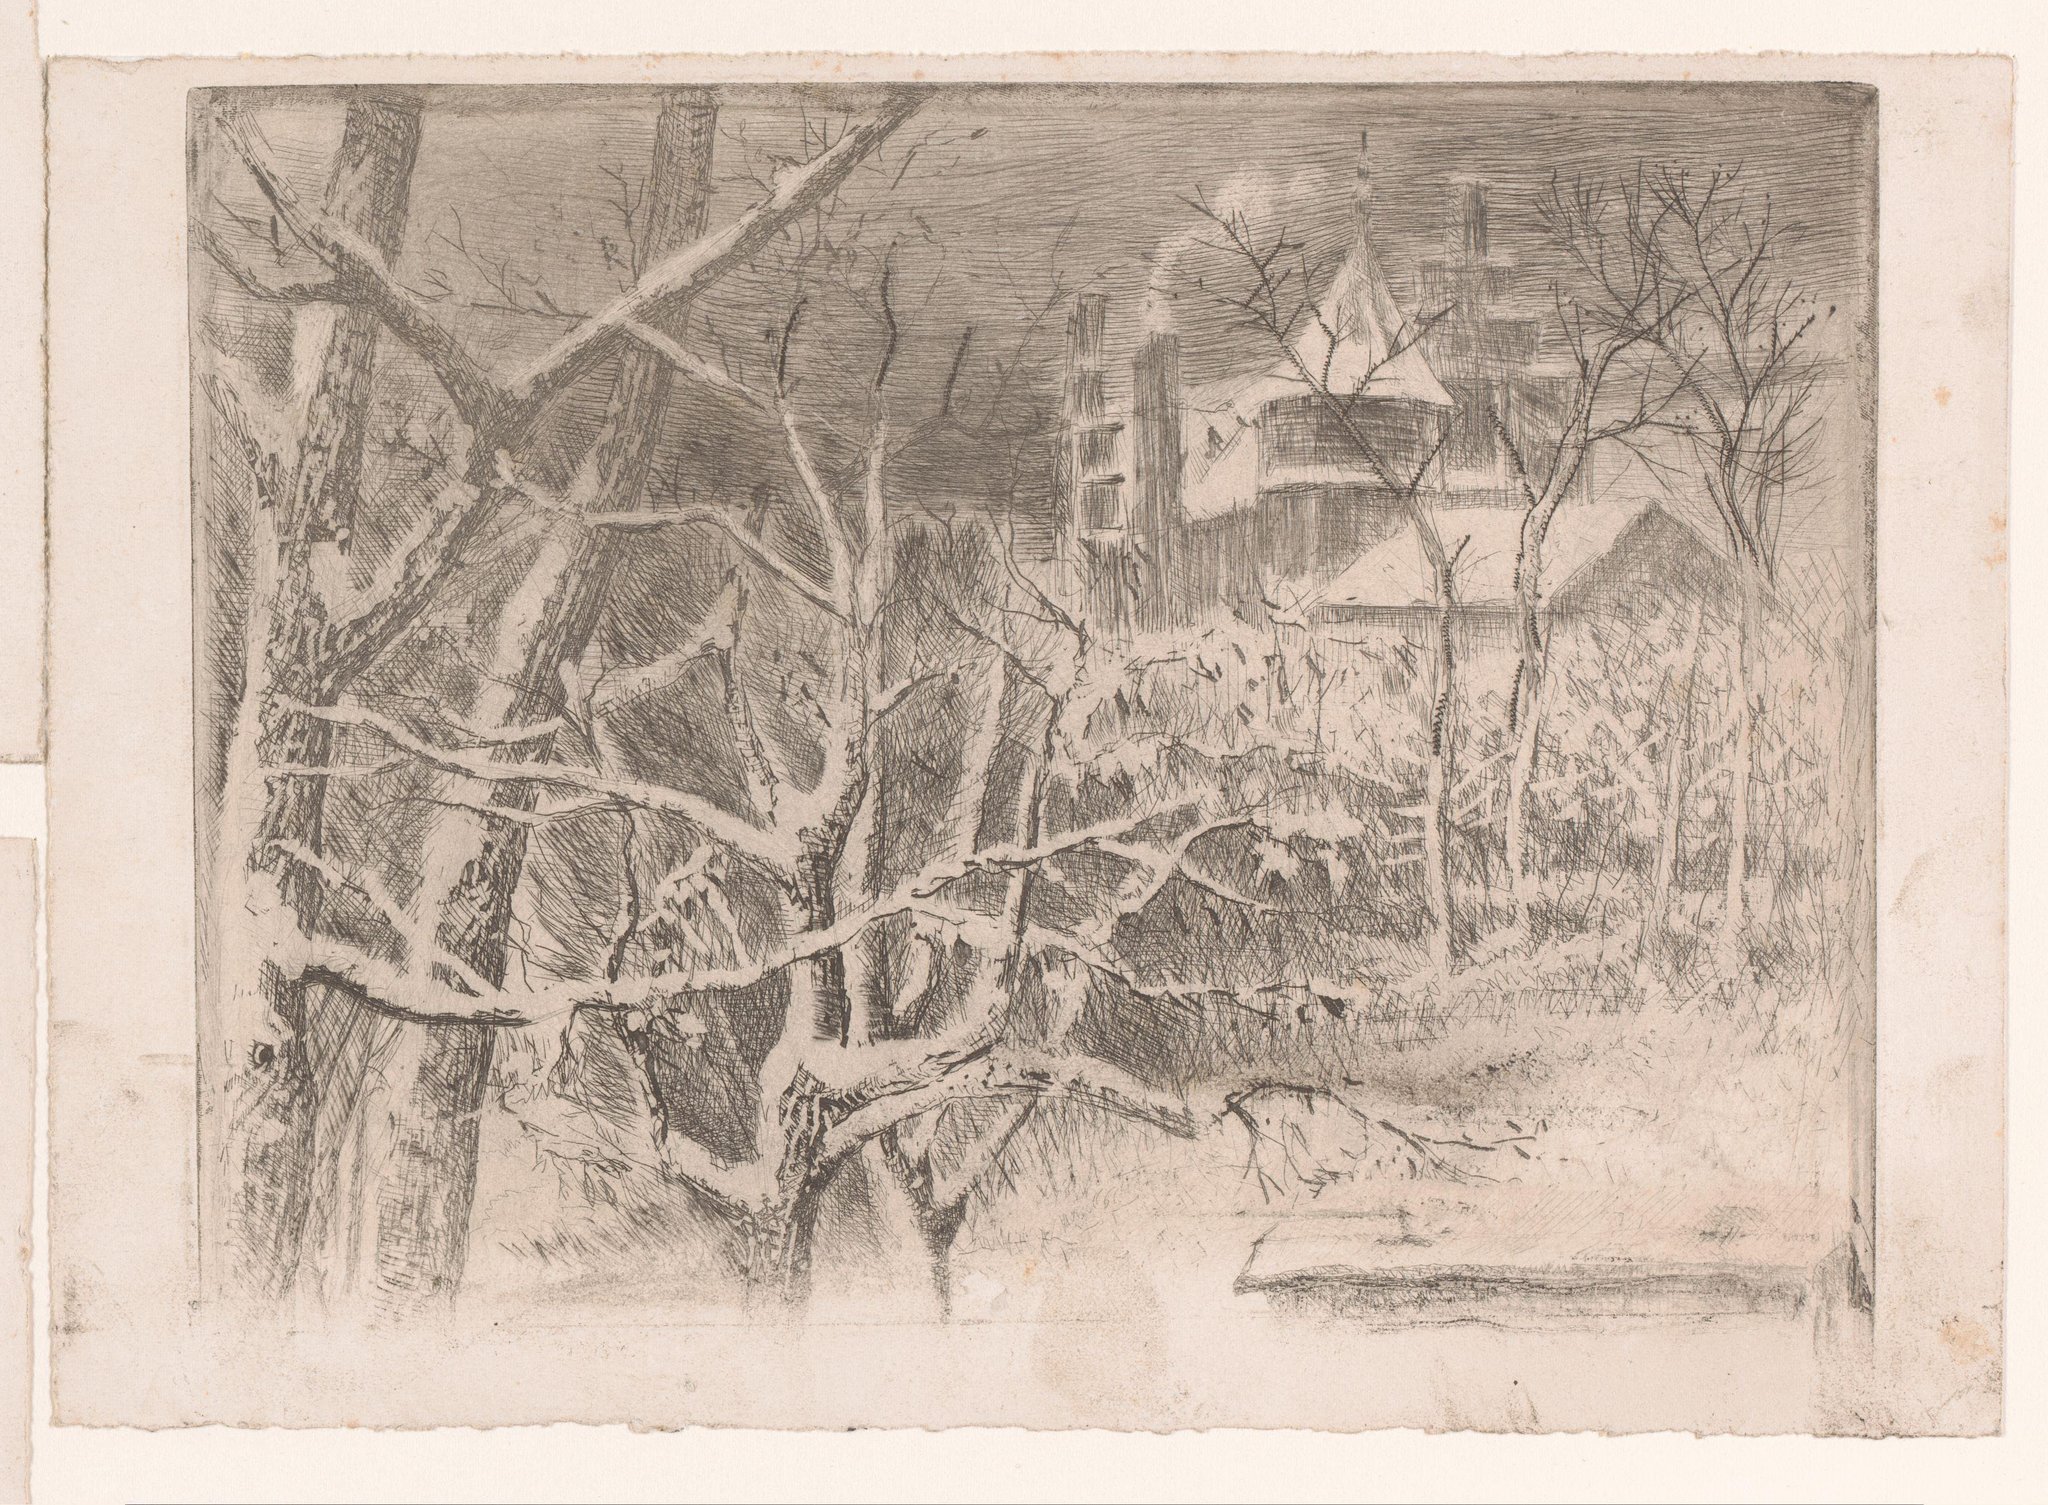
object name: print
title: Sneeuwlandschap met kasteel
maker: charles verlat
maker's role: painter, print maker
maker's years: 1824-1890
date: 1834-1890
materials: paper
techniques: etching, intaglio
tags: landscape with tower or castle, snow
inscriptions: collector's mark: Lugt 2228